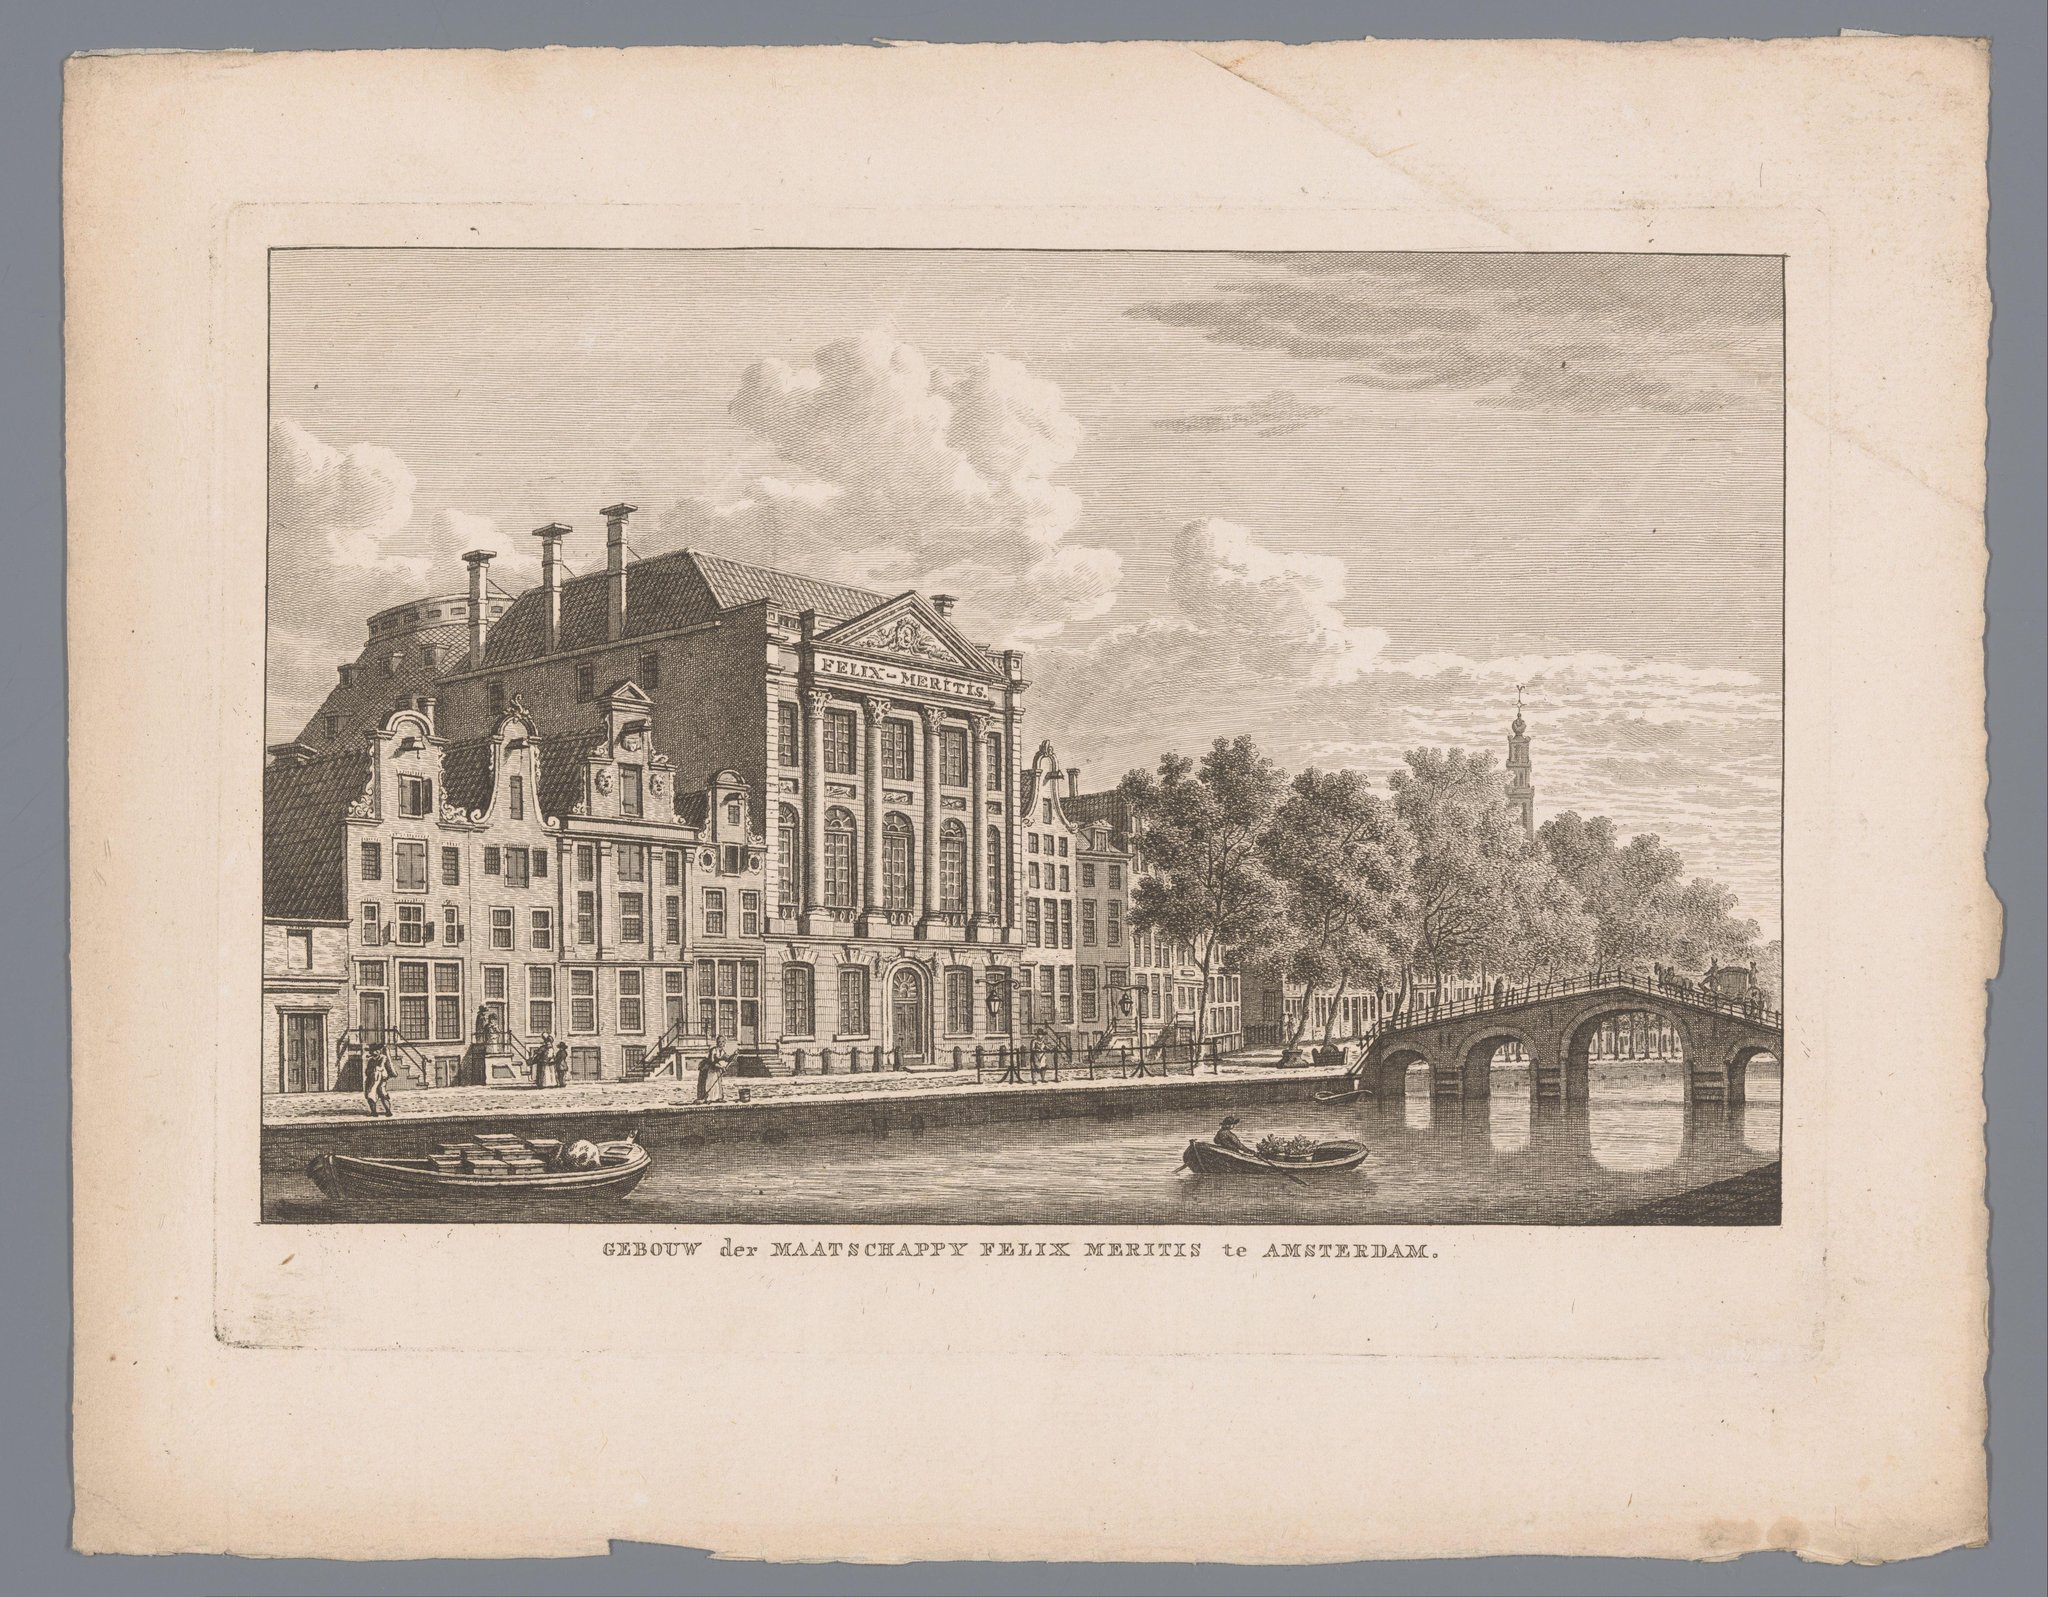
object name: print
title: Gebouw der Maatschappy Felix Meritis te Amsterdam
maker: carel frederik bendorp (i)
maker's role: print maker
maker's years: 1736-1814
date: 1786-1792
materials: paper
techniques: etching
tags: urban housing, rowing-boat, canoe, etc., bridge in city across river, canal, etc.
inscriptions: collector's mark: Lugt 2233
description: Huidige staat van prent gebruikt in: Vaderlandsche gezichten, of afbeeldingen van den tegenwoordigen staat der Vereenigde Nederlanden (…). Amsterdam: Hendrik Gartman, Willem Vermandel en Jan Willem Smit, 1786-1792. Uitgegeven in afleveringen met ieder een eigen bifolium en inhoudsopgave. Alle prenten in deze publicatie zijn gegraveerd door Carel Frederik Bendorp (I) en, in de meeste gevallen, gebaseerd op tekeningen van Jan Bulthuis. Latere staat van huidige prent, met gedrukte Franse titel, is uitgegeven als onderdeel van een plaatwerk uit ca. 1824-1825 met 74 (ongenummerde) platen van de belangrijkste topografische gezichten en verschillende zeden en gewoonten in het Verenigd Koninkrijk der Nederlanden, getiteld 'Tableau des principales vues des palais et édifices : représentations et des coutumes et usages, dans les provinces septentrionales du Royaume des Pays-Bas'.